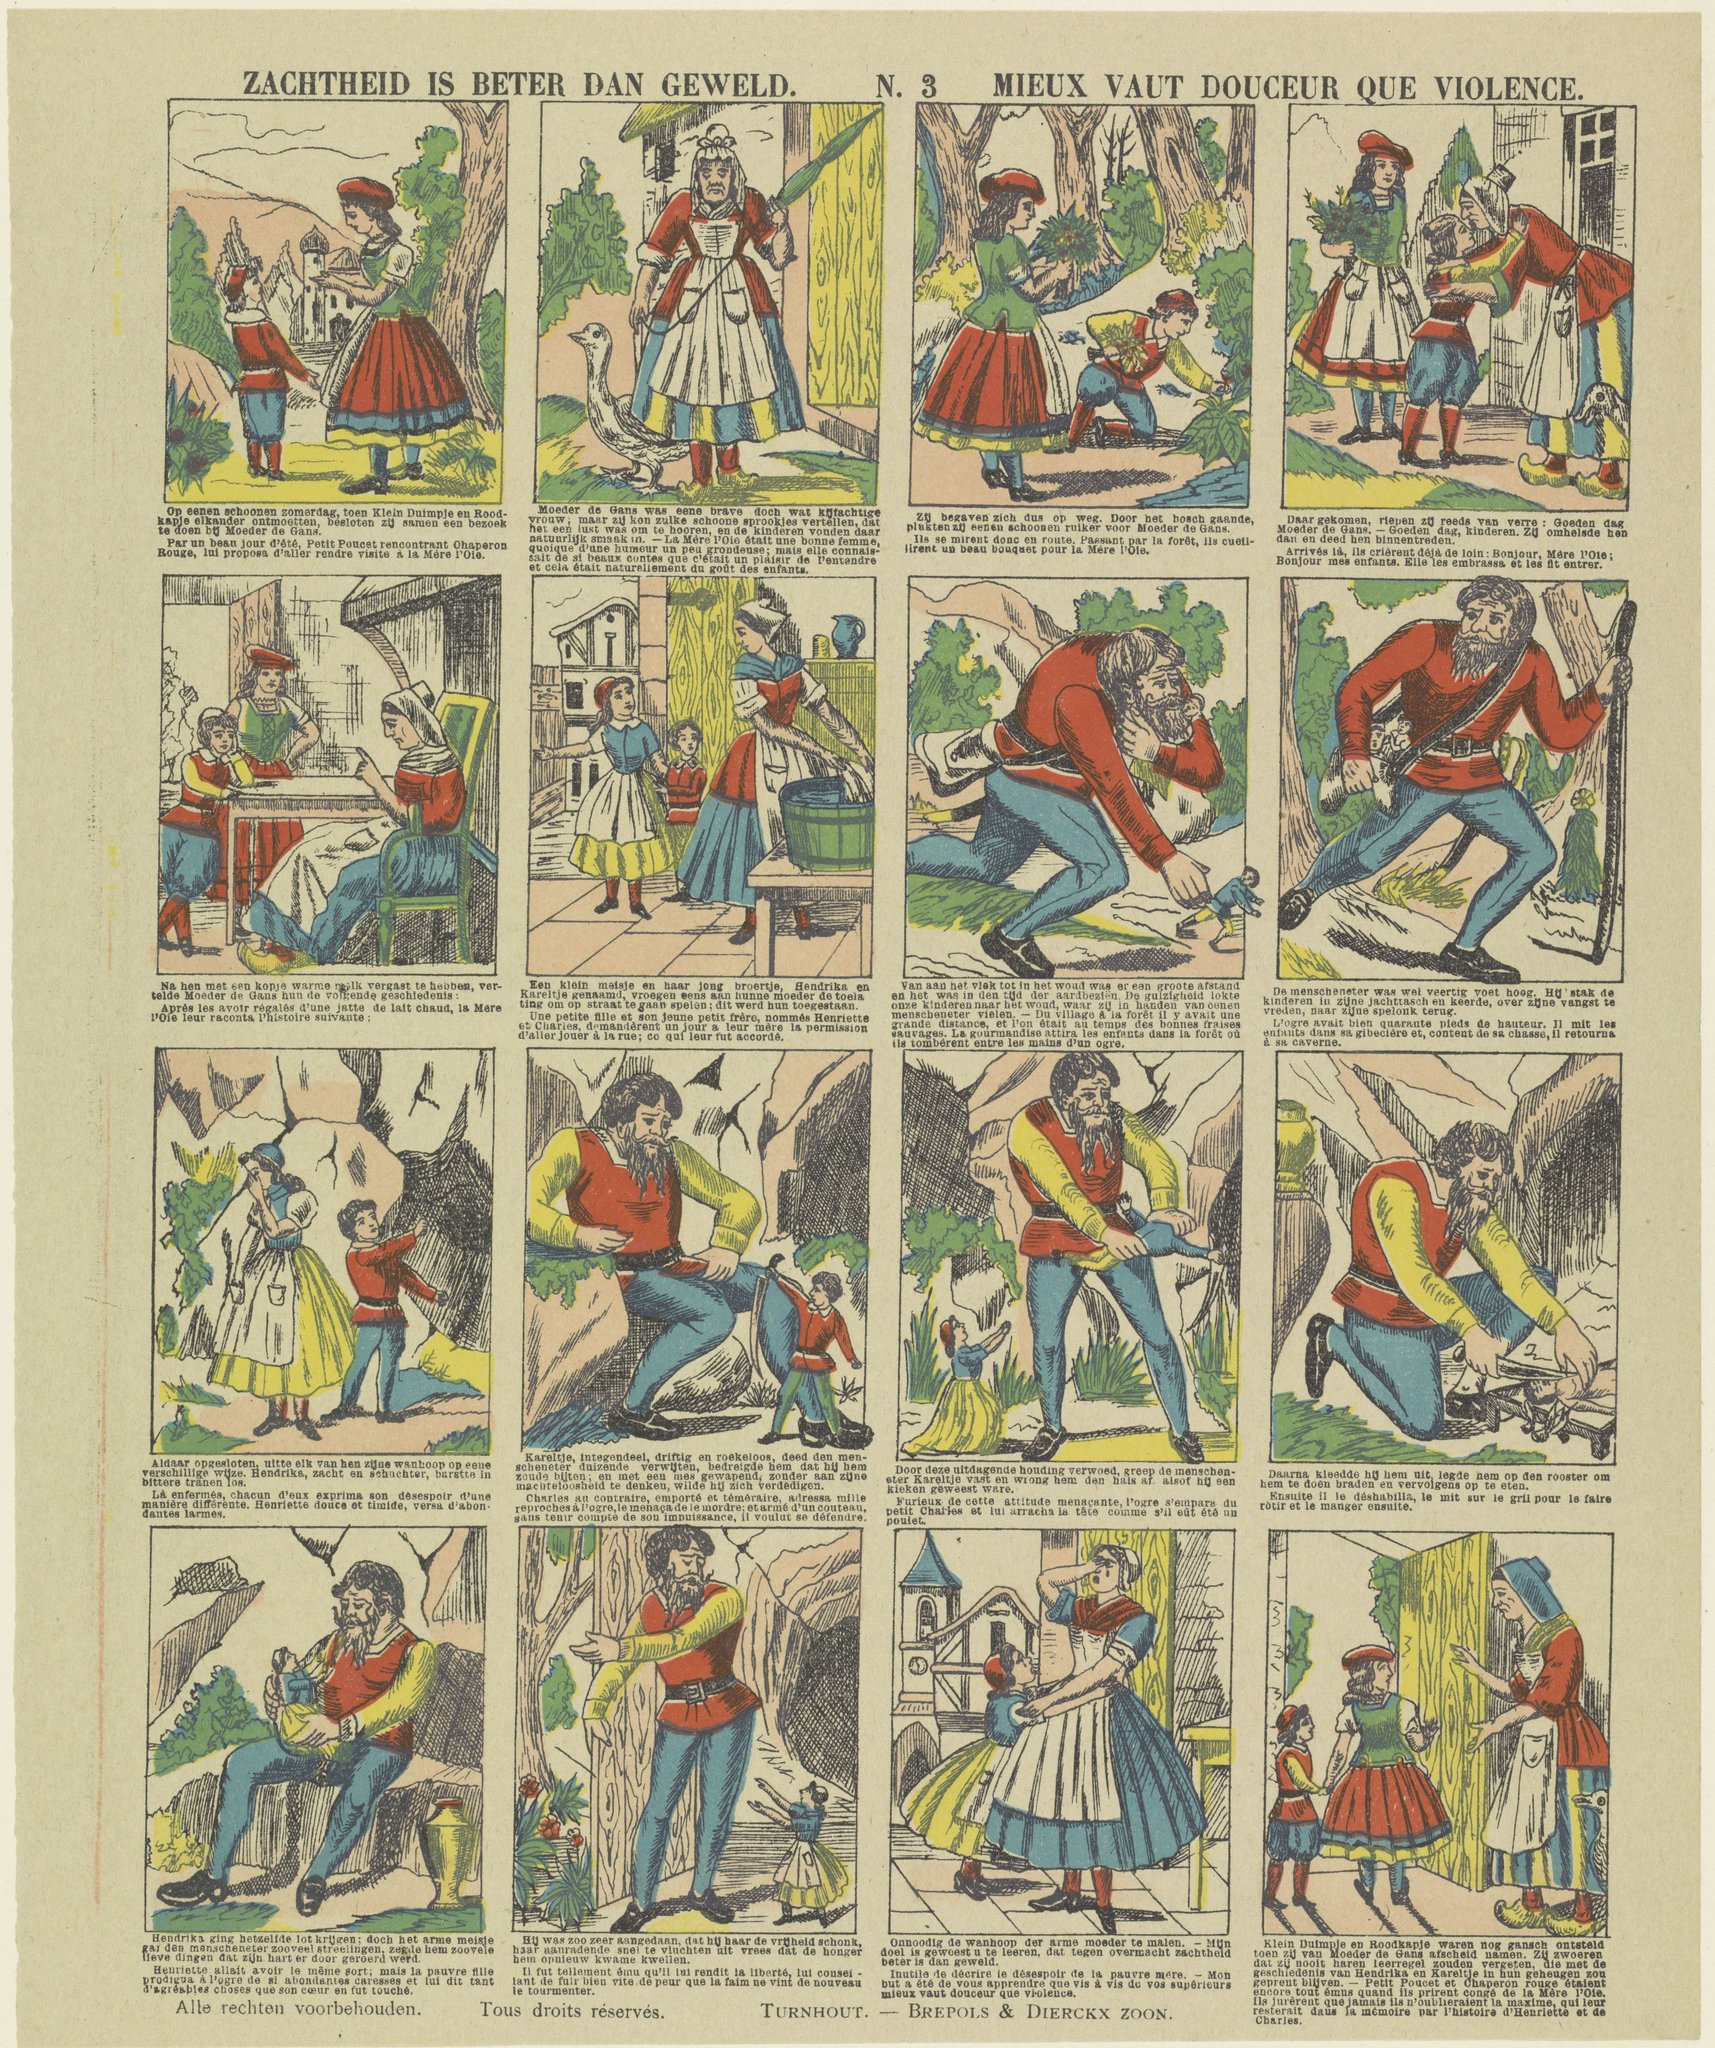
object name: popular print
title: Zachtheid is beter dan geweld / Mieux vaut douceur que violence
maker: Anonymous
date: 1833-1911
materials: paper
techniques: lithograph, letterpress printing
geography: turnhout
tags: tales and fairy tales, tales and fairy tales: little red riding-hood, cannibalism, tales and fairy tales: little thumbling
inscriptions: collector's mark: Lugt 2760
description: Blad met 16 voorstellingen over Moeder Gans die Roodkapje en Klein Duimpje een verhaal over een mensenetende reus verteld. Onder elke afbeelding een onderschrift in het Nederlands en in het Frans. Genummerd midden boven: N. 3.